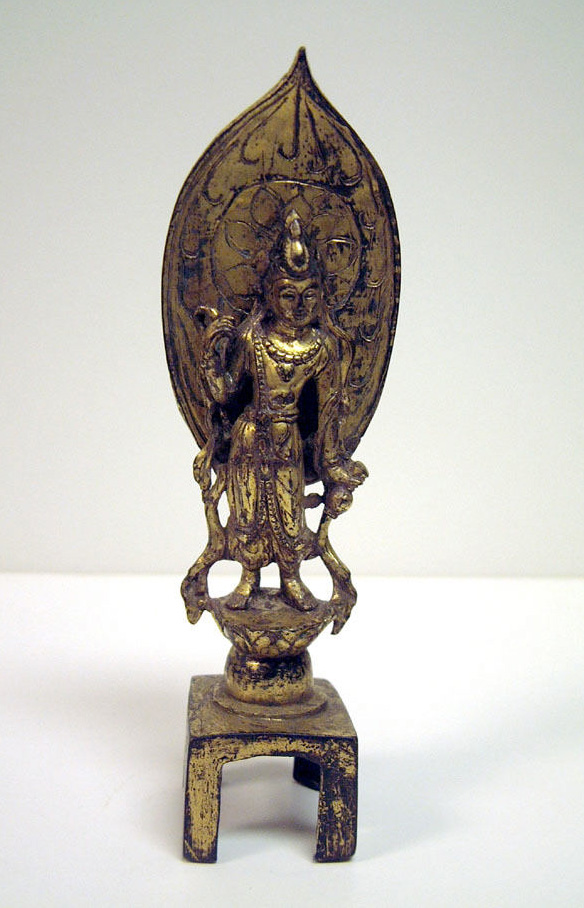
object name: figure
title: Standing Bodhisattva Avalokiteshvara (Guanyin)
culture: chinese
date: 618-907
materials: gilt bronze